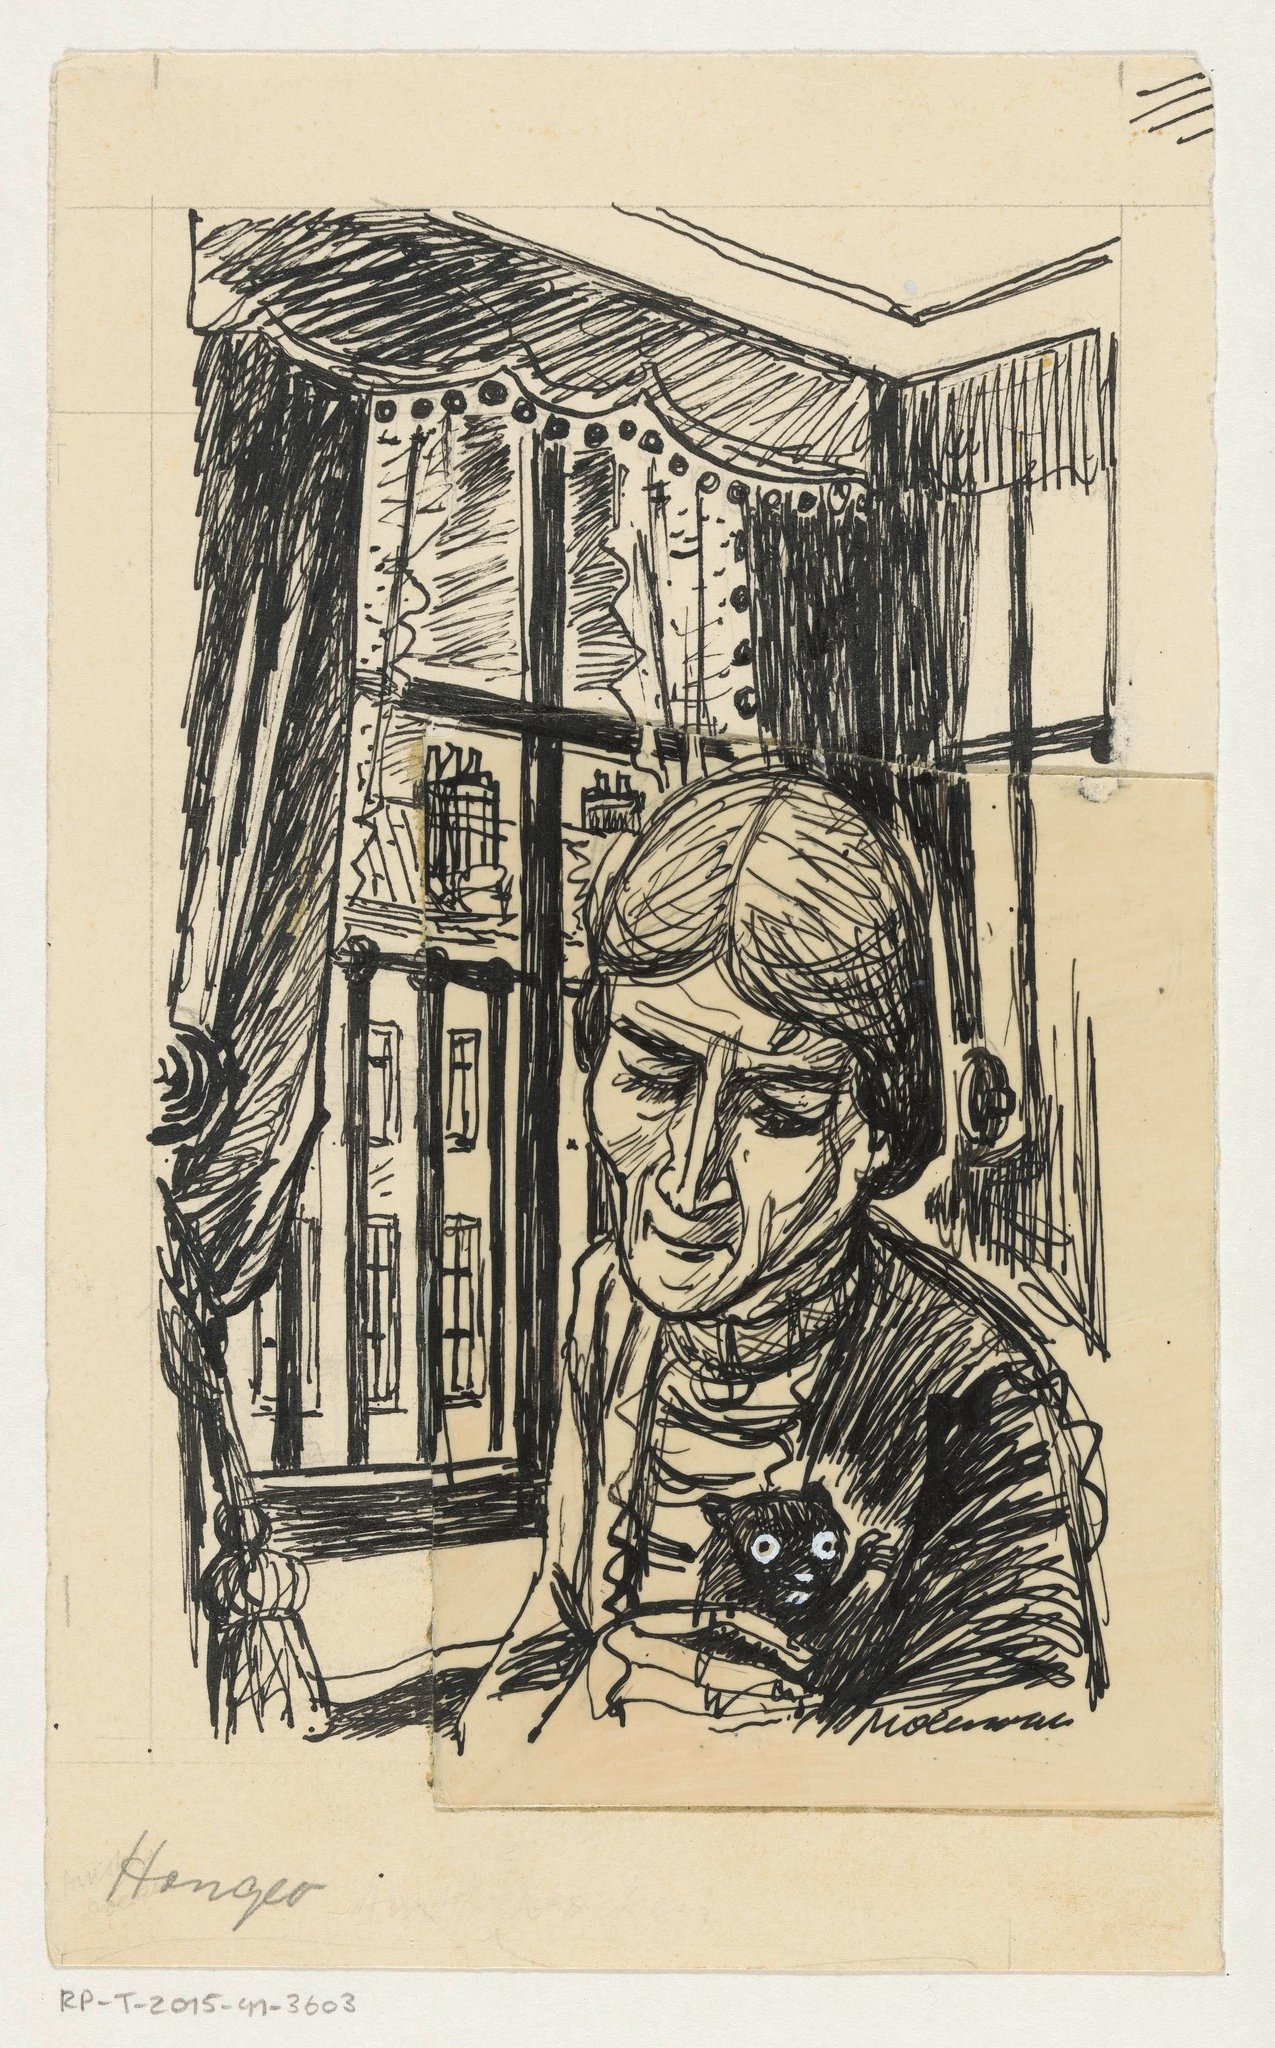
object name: drawing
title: Vrouw met kat bij een venster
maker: Anonymous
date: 1920-1950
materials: paint, ink, paper, pencil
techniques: brush, pen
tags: window, cat, thin (human type)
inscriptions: :, signature: ‘Molen[...]’, collector's mark: Lugt 2228a, annotation: ‘Honger’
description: Een vrouw met een uitgemergeld gezicht zit met een kat op schoot bij een venster. Door het raam zijn de huizen aan de overzijde van de straat te zien.